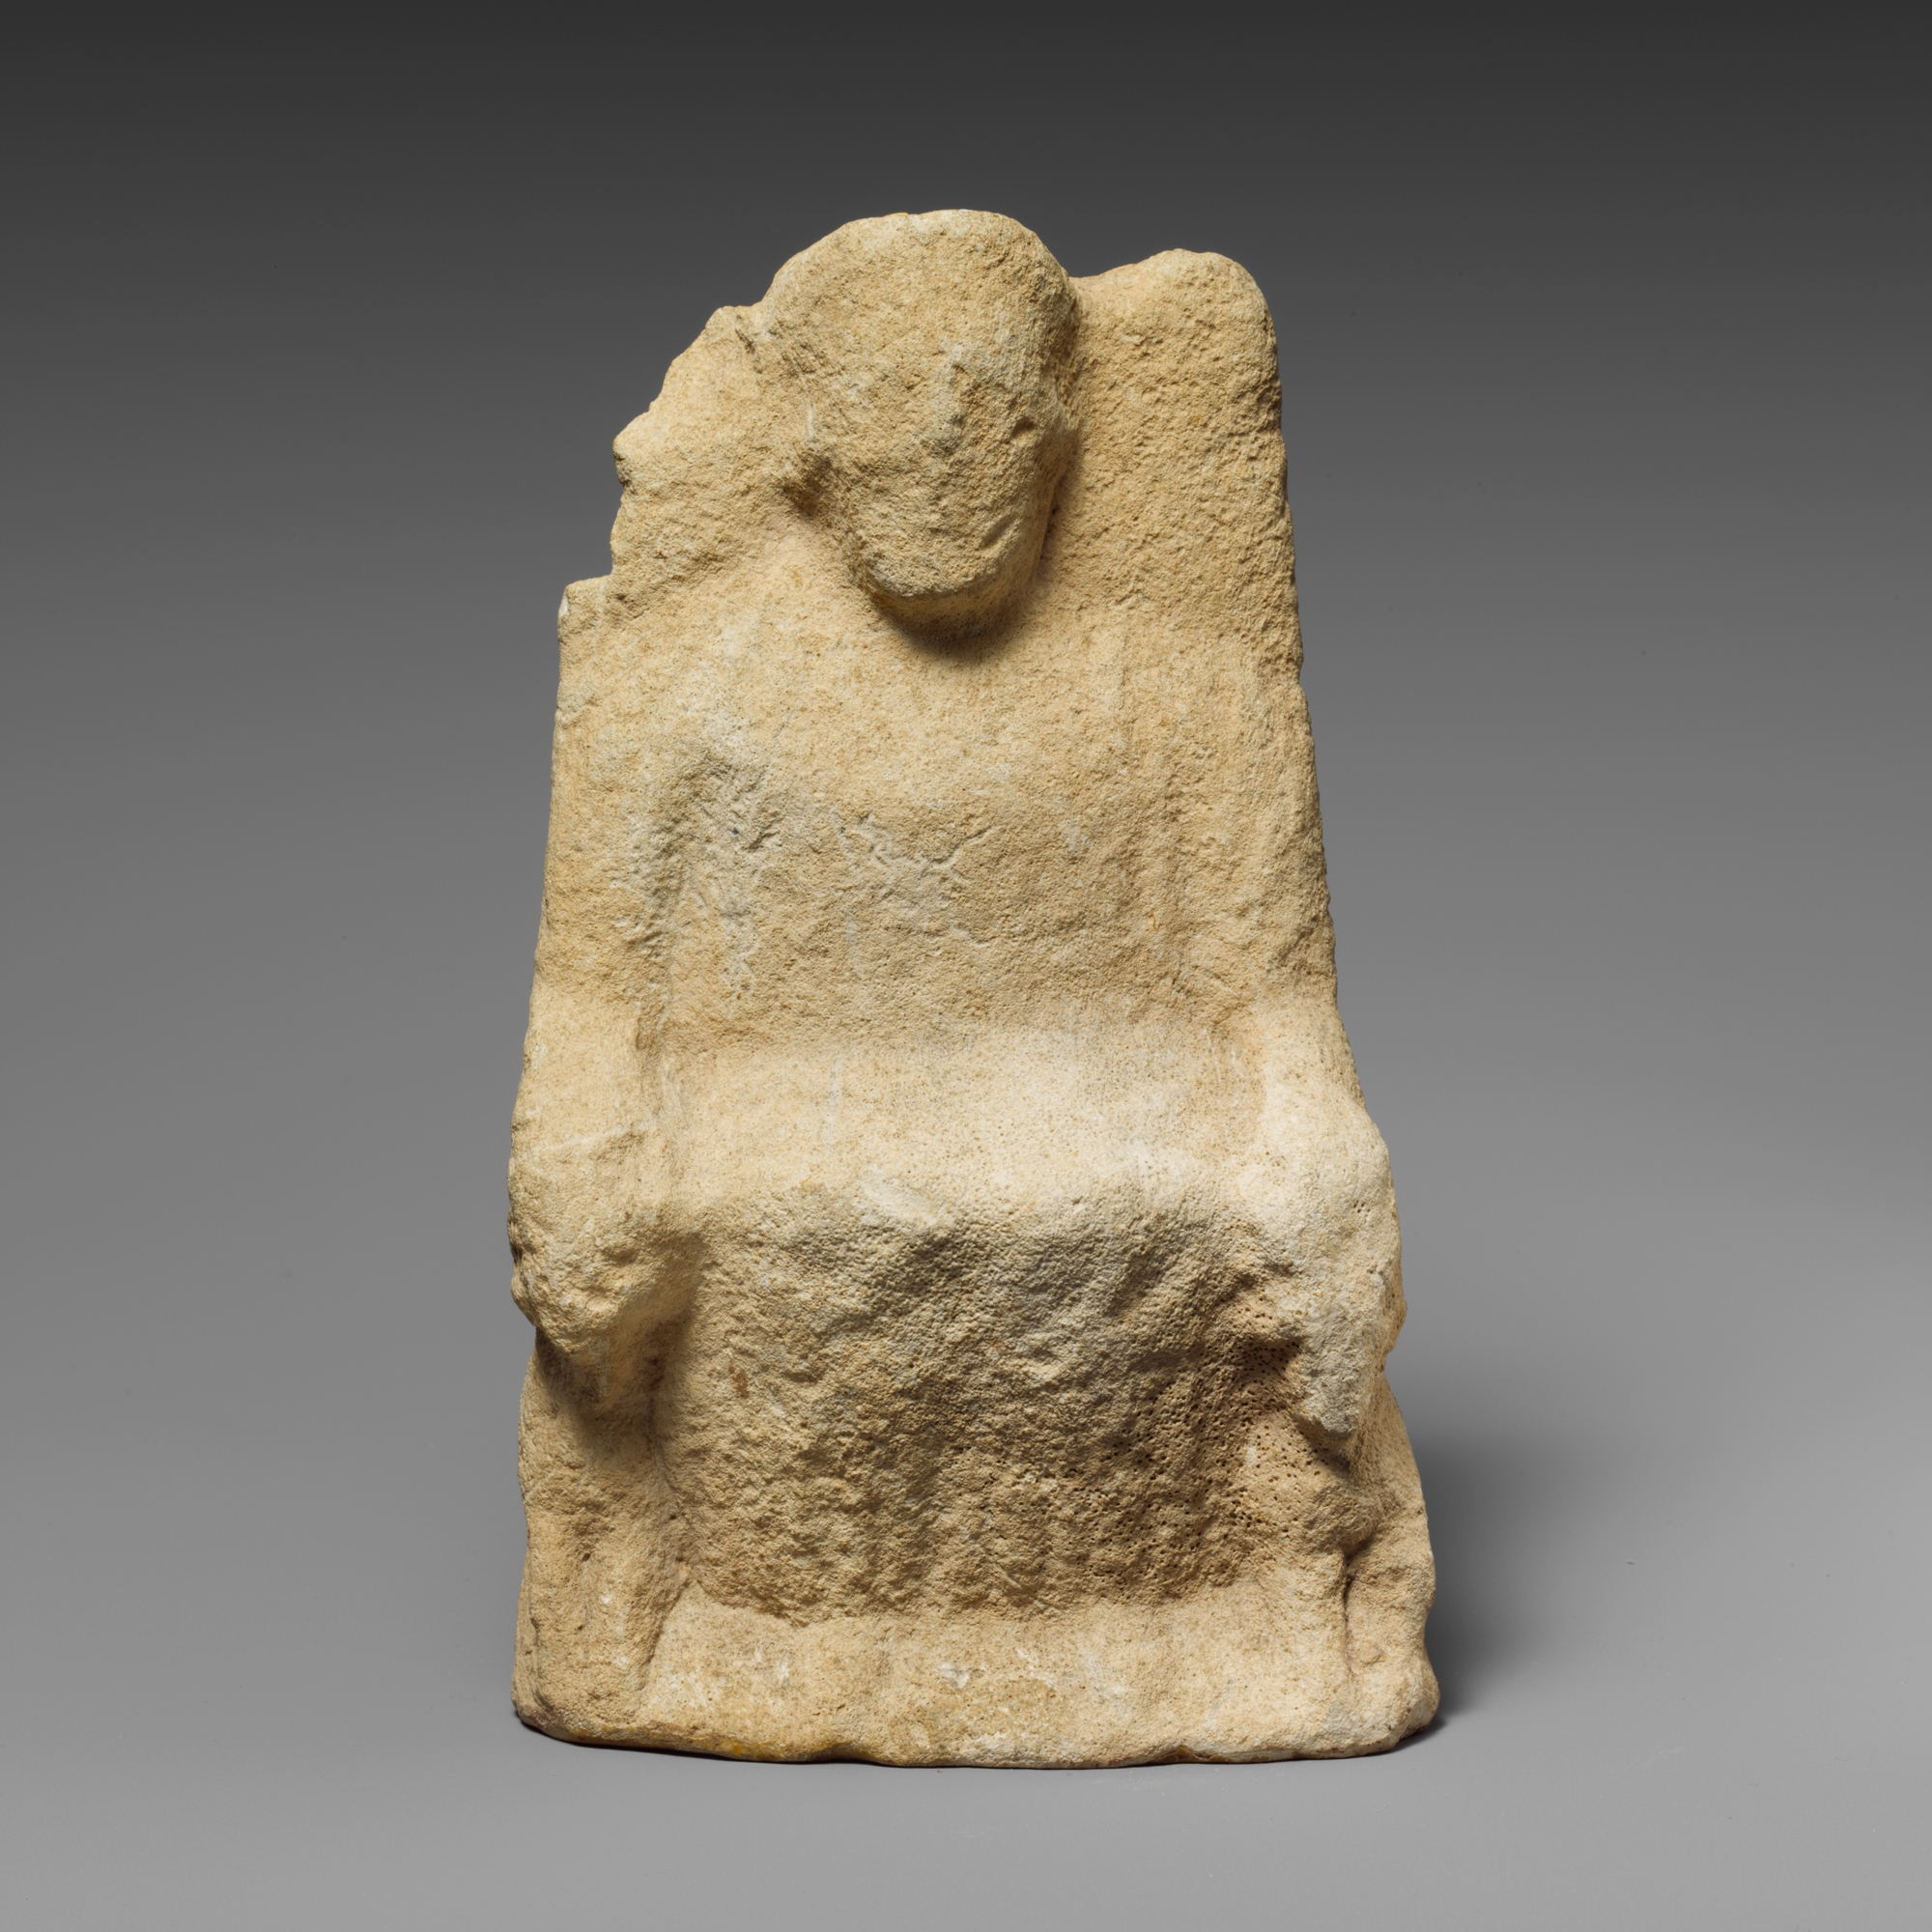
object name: statuette of zeus ammon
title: Limestone statuette of Zeus Ammon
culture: cypriot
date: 400-301 BCE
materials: limestone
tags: zeus